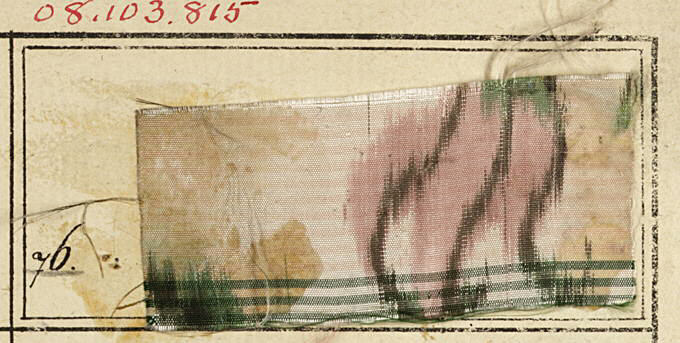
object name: ribbon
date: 1701-1900